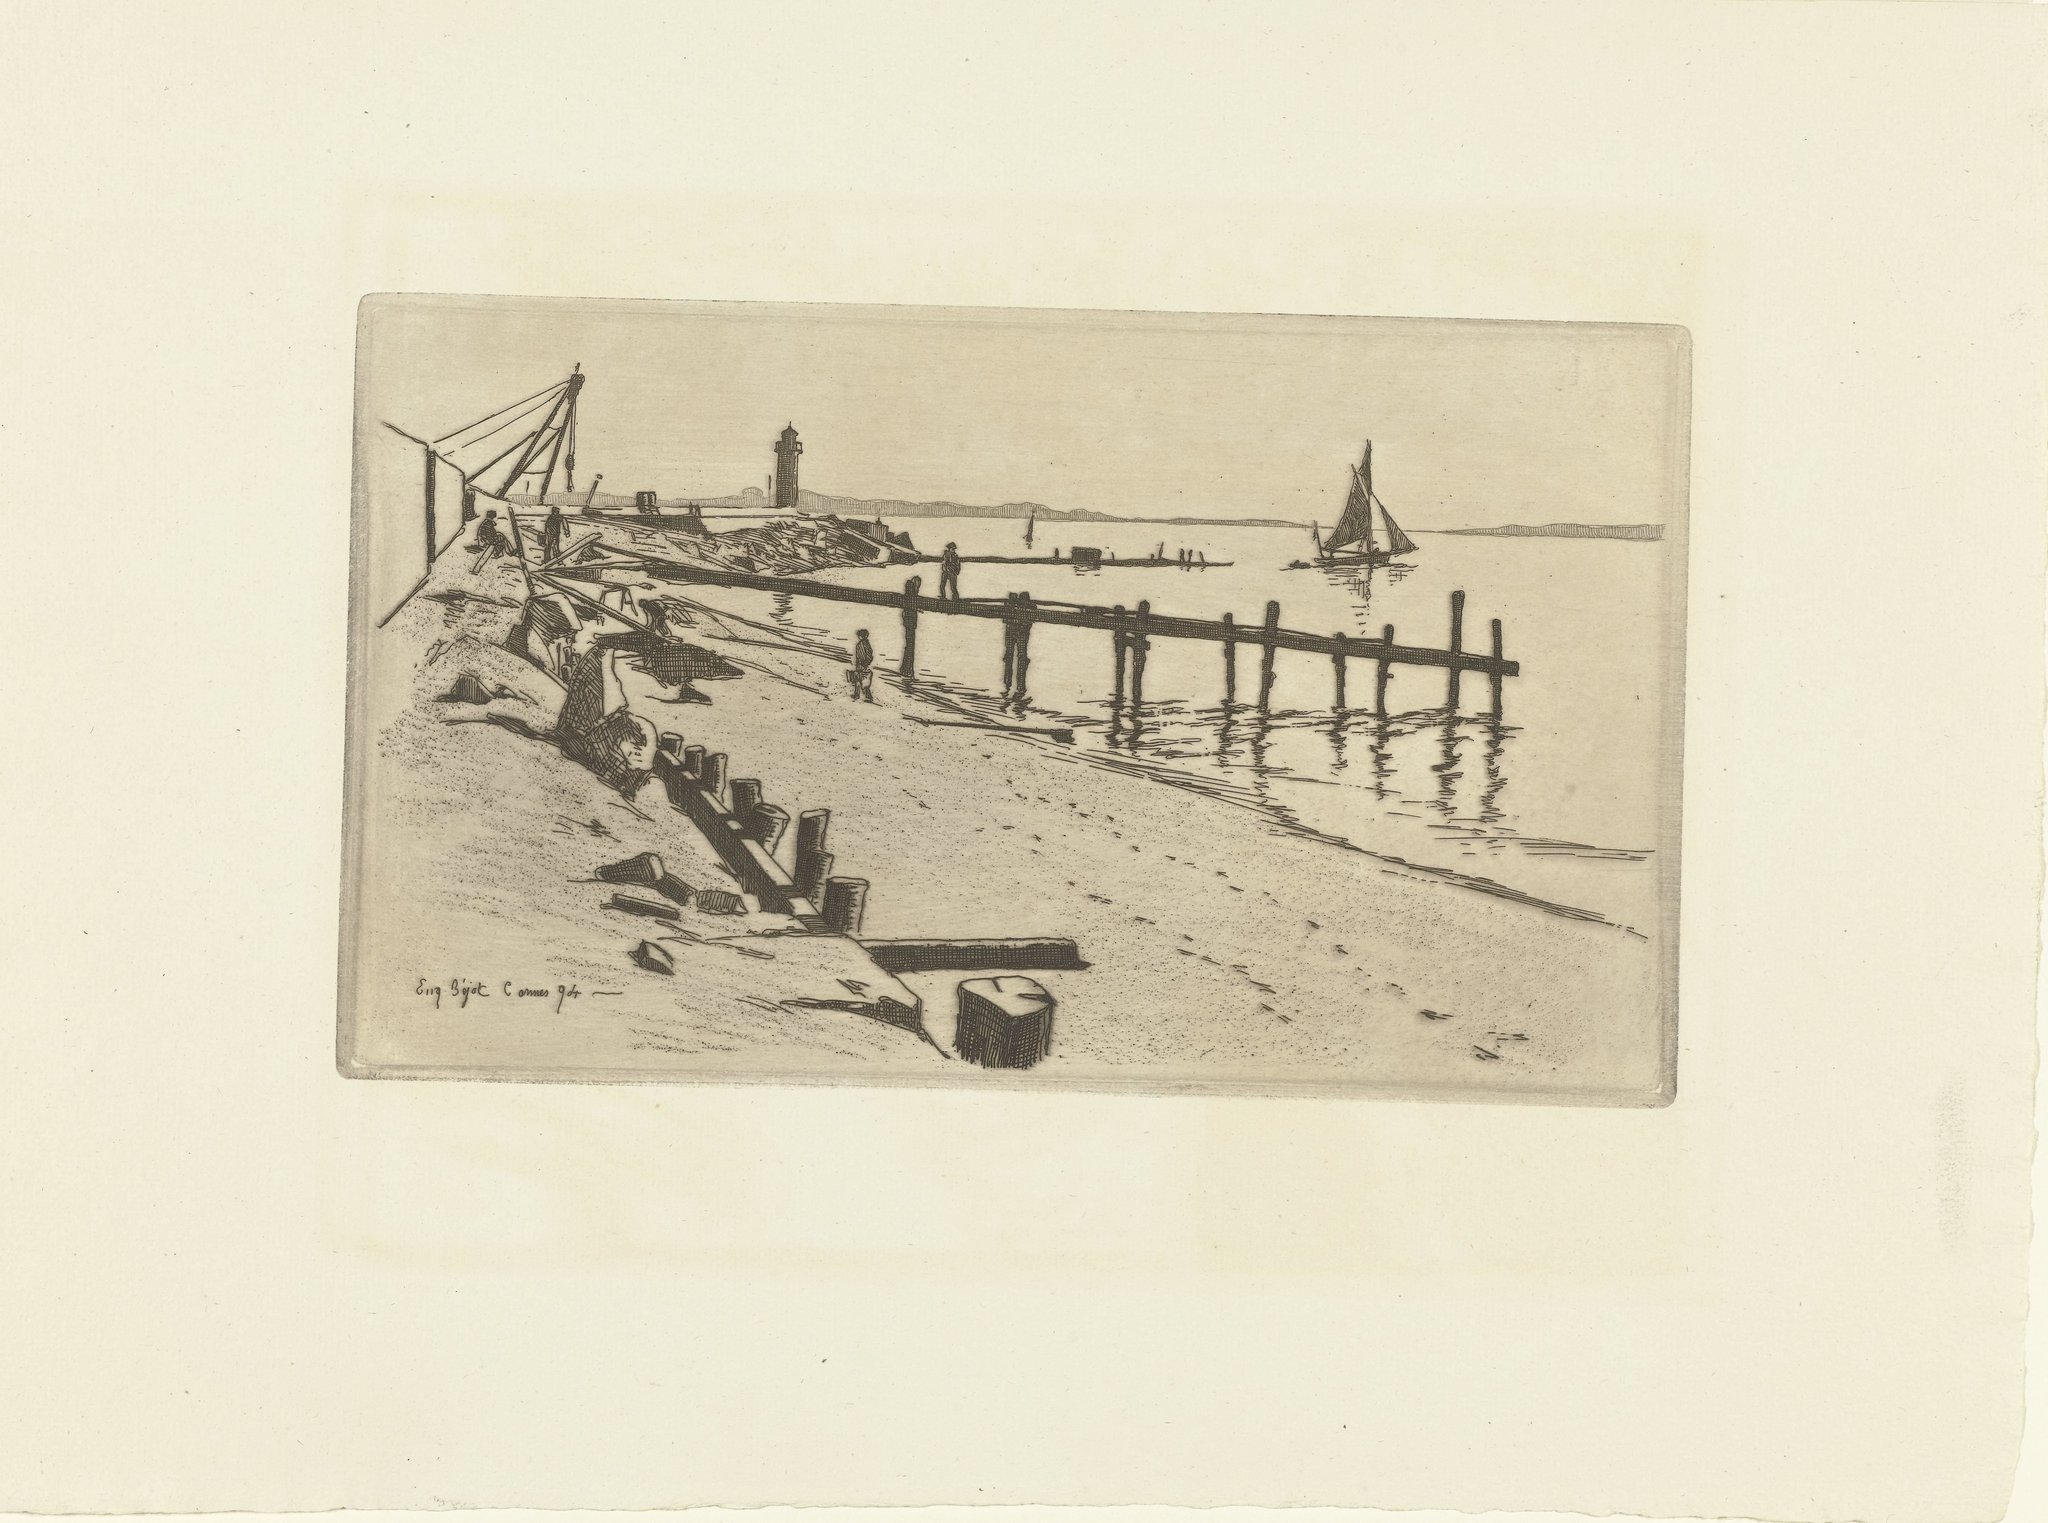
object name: print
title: Marine à Cannes 1894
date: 1894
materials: paper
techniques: etching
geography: paris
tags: ship bound for the harbour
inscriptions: collector's mark: Lugt 2228, collector's mark: Lugt 2760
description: Verschenen in album met tien originele prenten als supplement bij tijdschrift: L'Epreuve, editie nr. 11, 1895, prent nr. 5